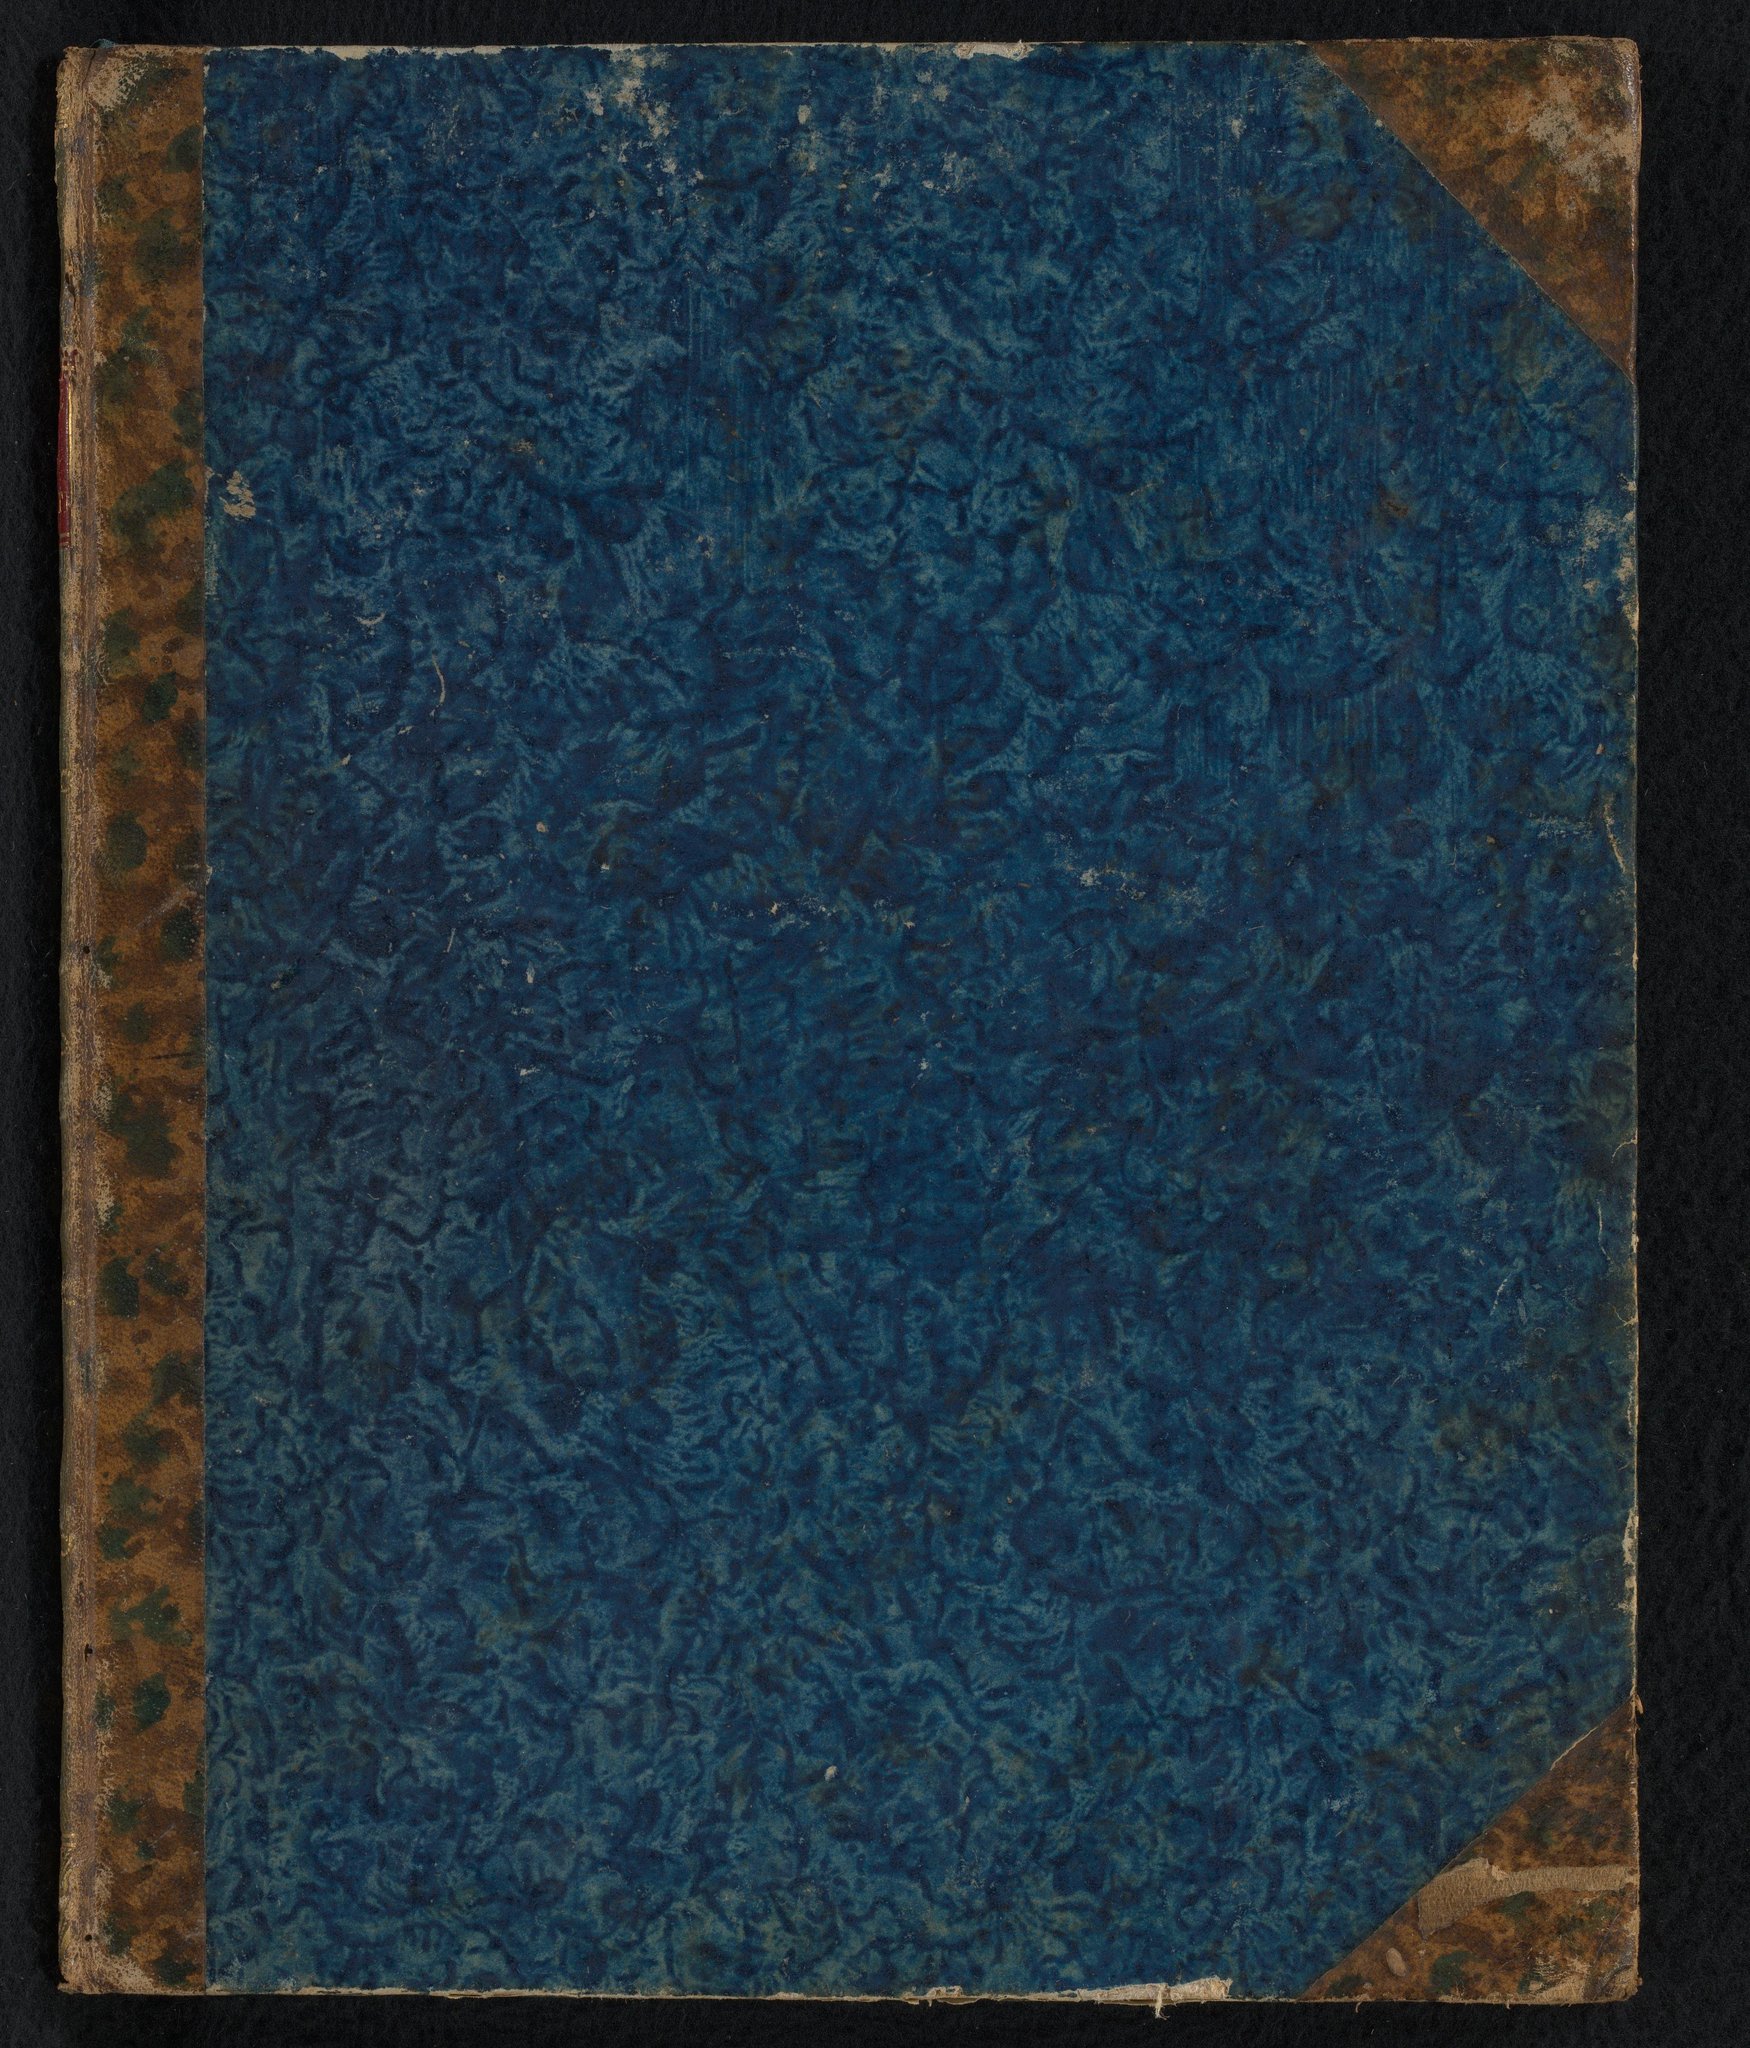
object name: prentrecueil, prentenalbum, prentalbum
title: Prentenalbum met 40 voorstellingen van hoofden, figuren, heiligen, mythen, trofeeën en de vier seizoenen.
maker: benigno bossi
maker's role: print maker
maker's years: 1727-1792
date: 1754-1772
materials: cardboard, leather, paper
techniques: aquatint, etching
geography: italy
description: Prentenalbum met 36 bladen waarop 40 prenten zijn gedrukt.